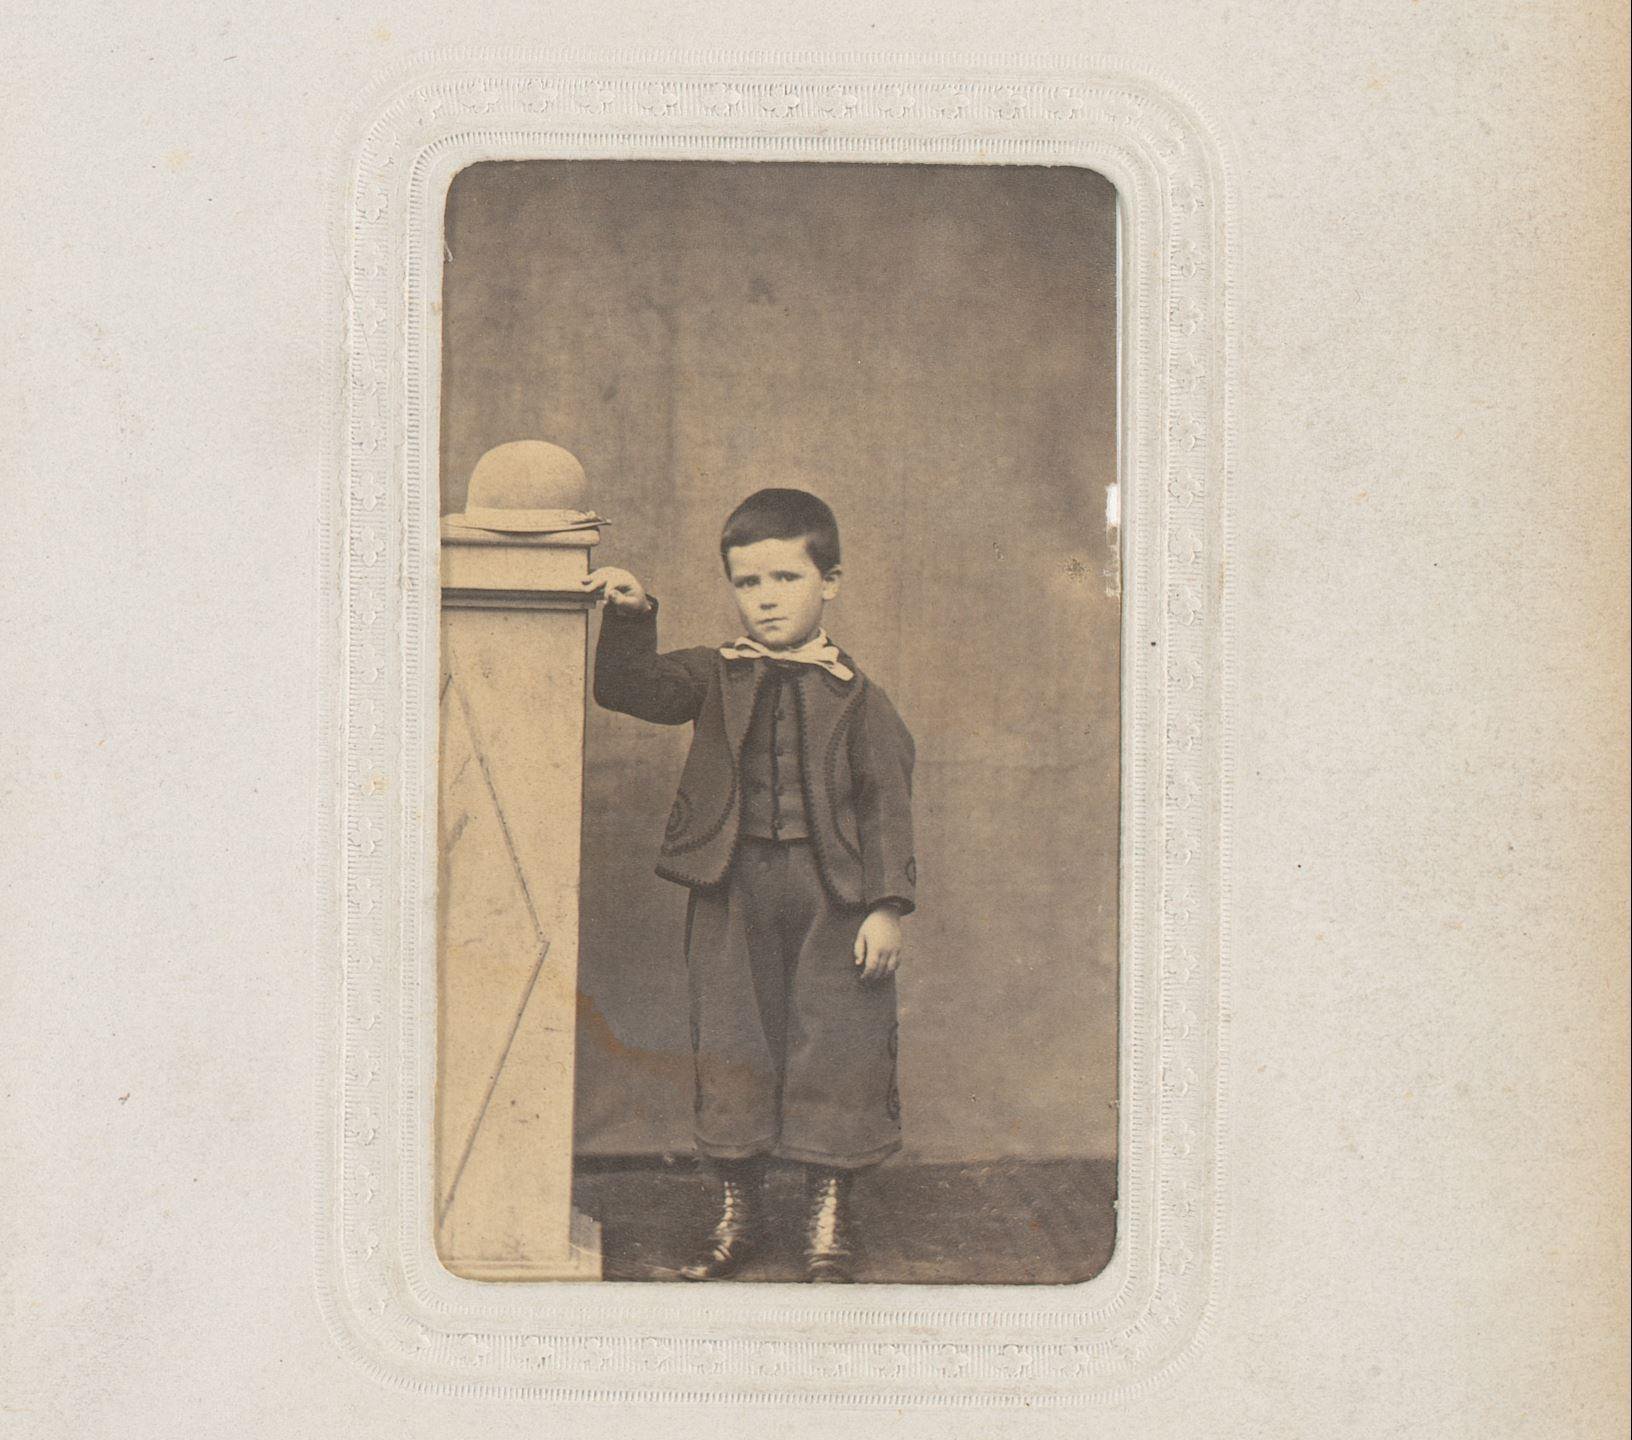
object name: album leaf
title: Portret van een jongen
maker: Anonymous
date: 1860-1890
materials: cardboard, photographic support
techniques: albumen print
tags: boy (child between toddler and youth), historical persons